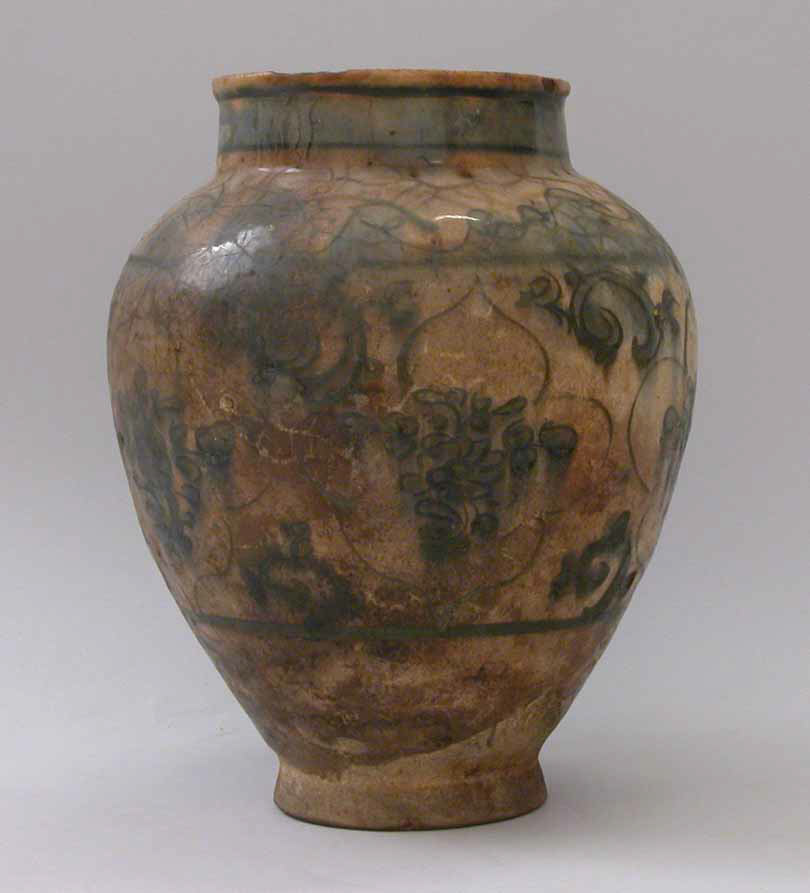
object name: jar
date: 1701-1800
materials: stonepaste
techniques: painting, underglaze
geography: iran